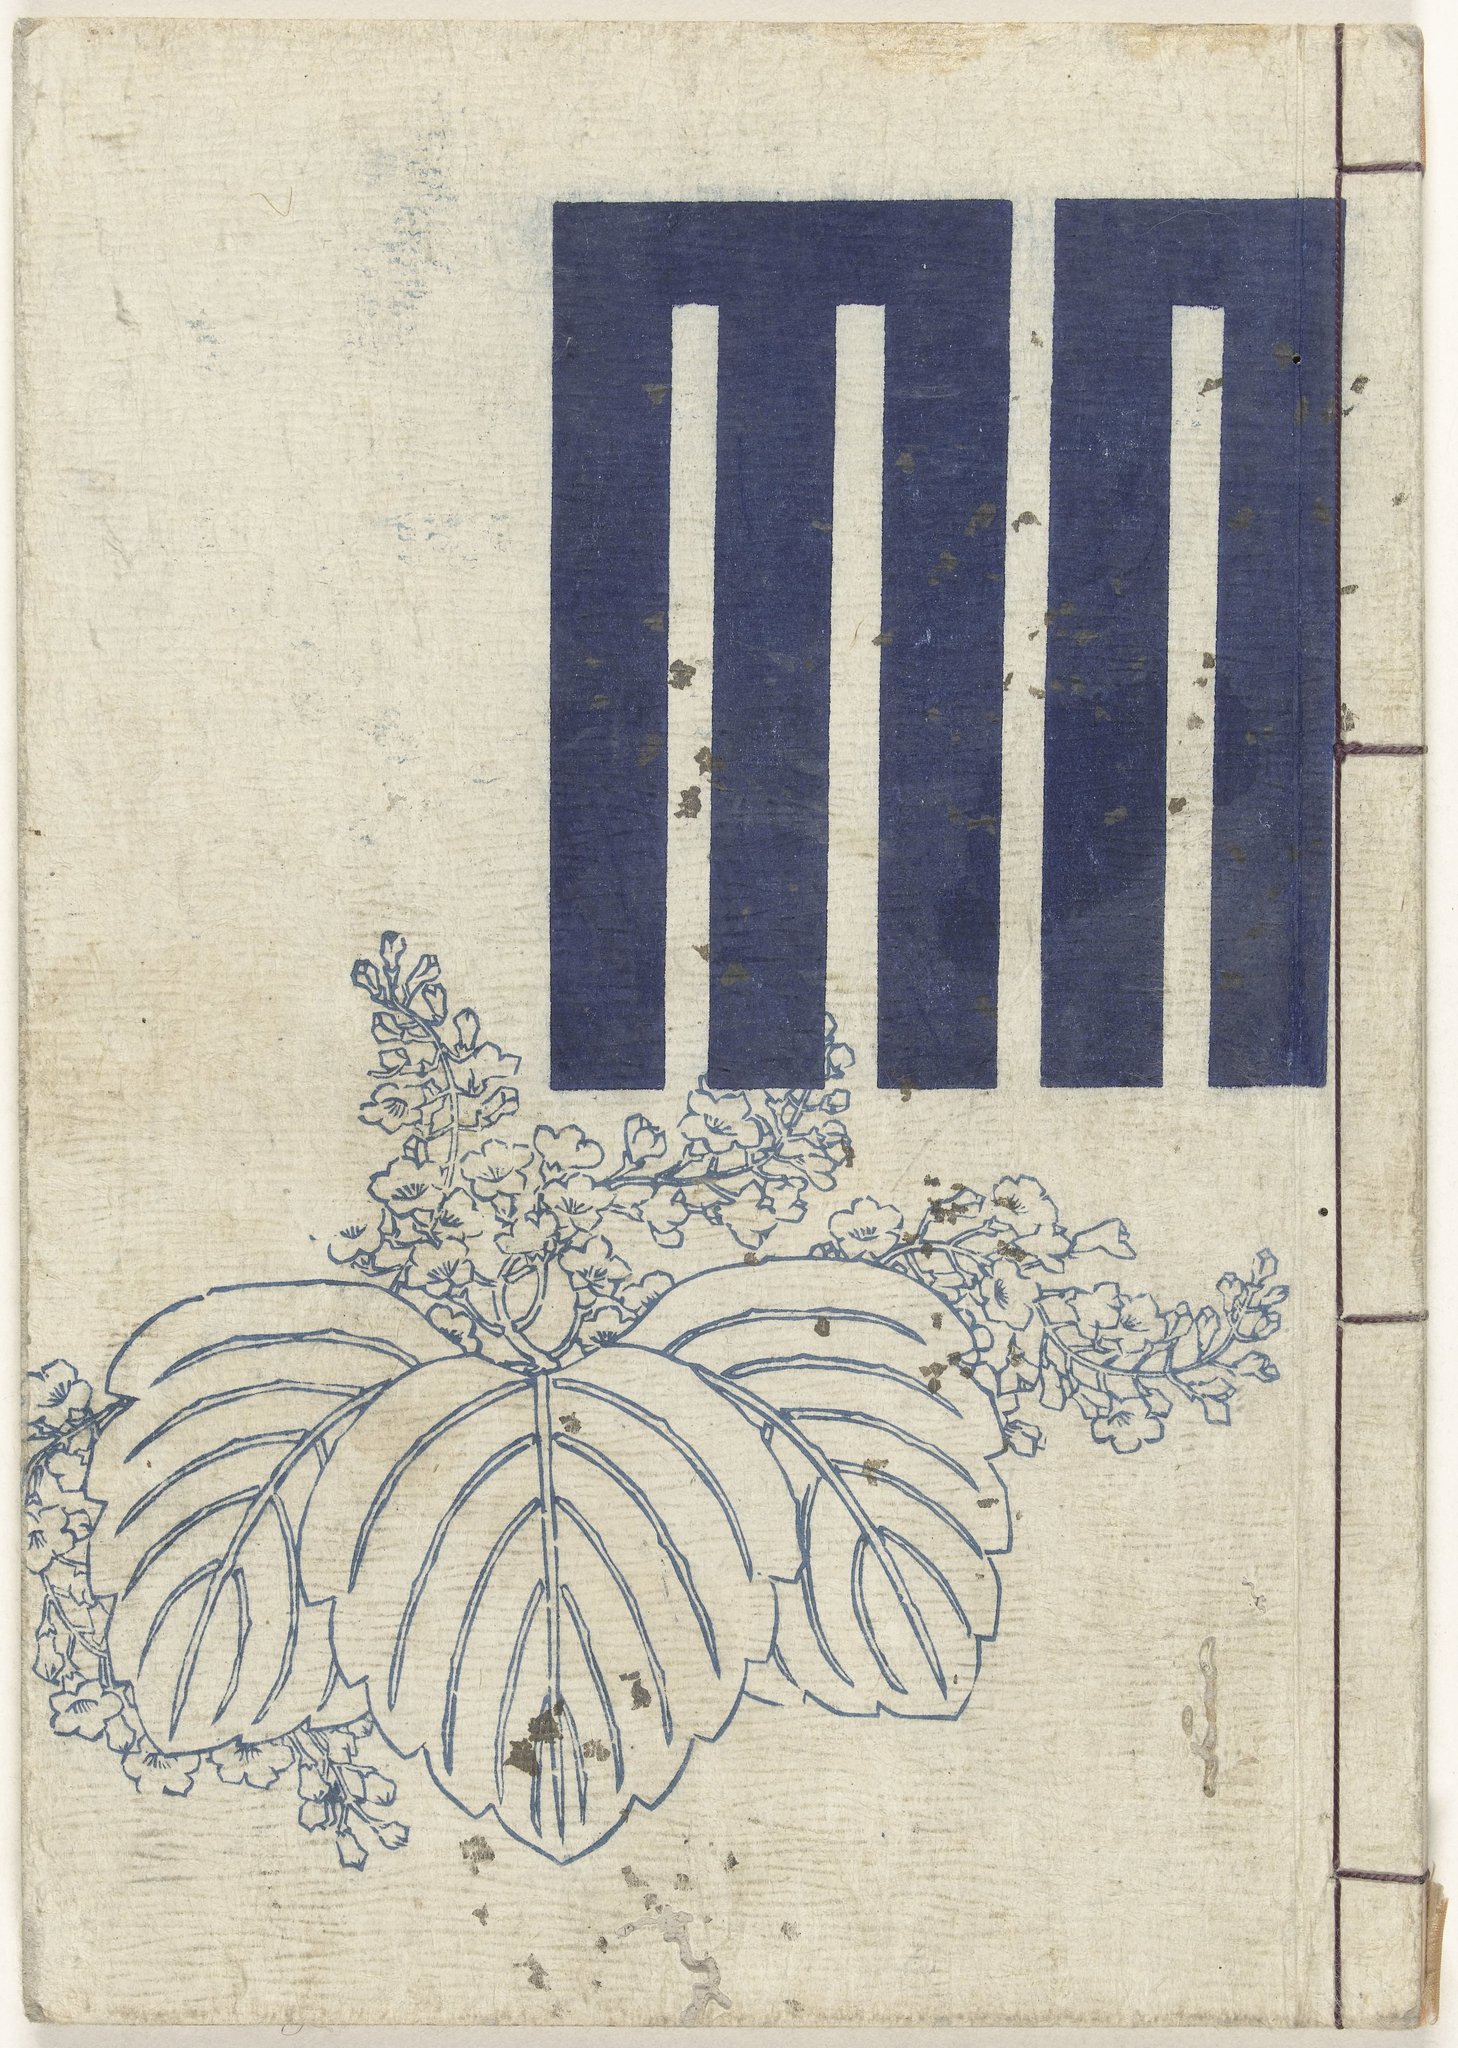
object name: book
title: Shunga album. Murasaki uit Edo en Genji uit het Yoshiwara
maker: utagawa kuniyoshi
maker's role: draughtsman, print maker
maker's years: 1798-1861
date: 1830-1835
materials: gold powder, paper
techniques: blind stamped, woodcut, polish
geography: japan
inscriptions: collector's mark: Lugt 2228